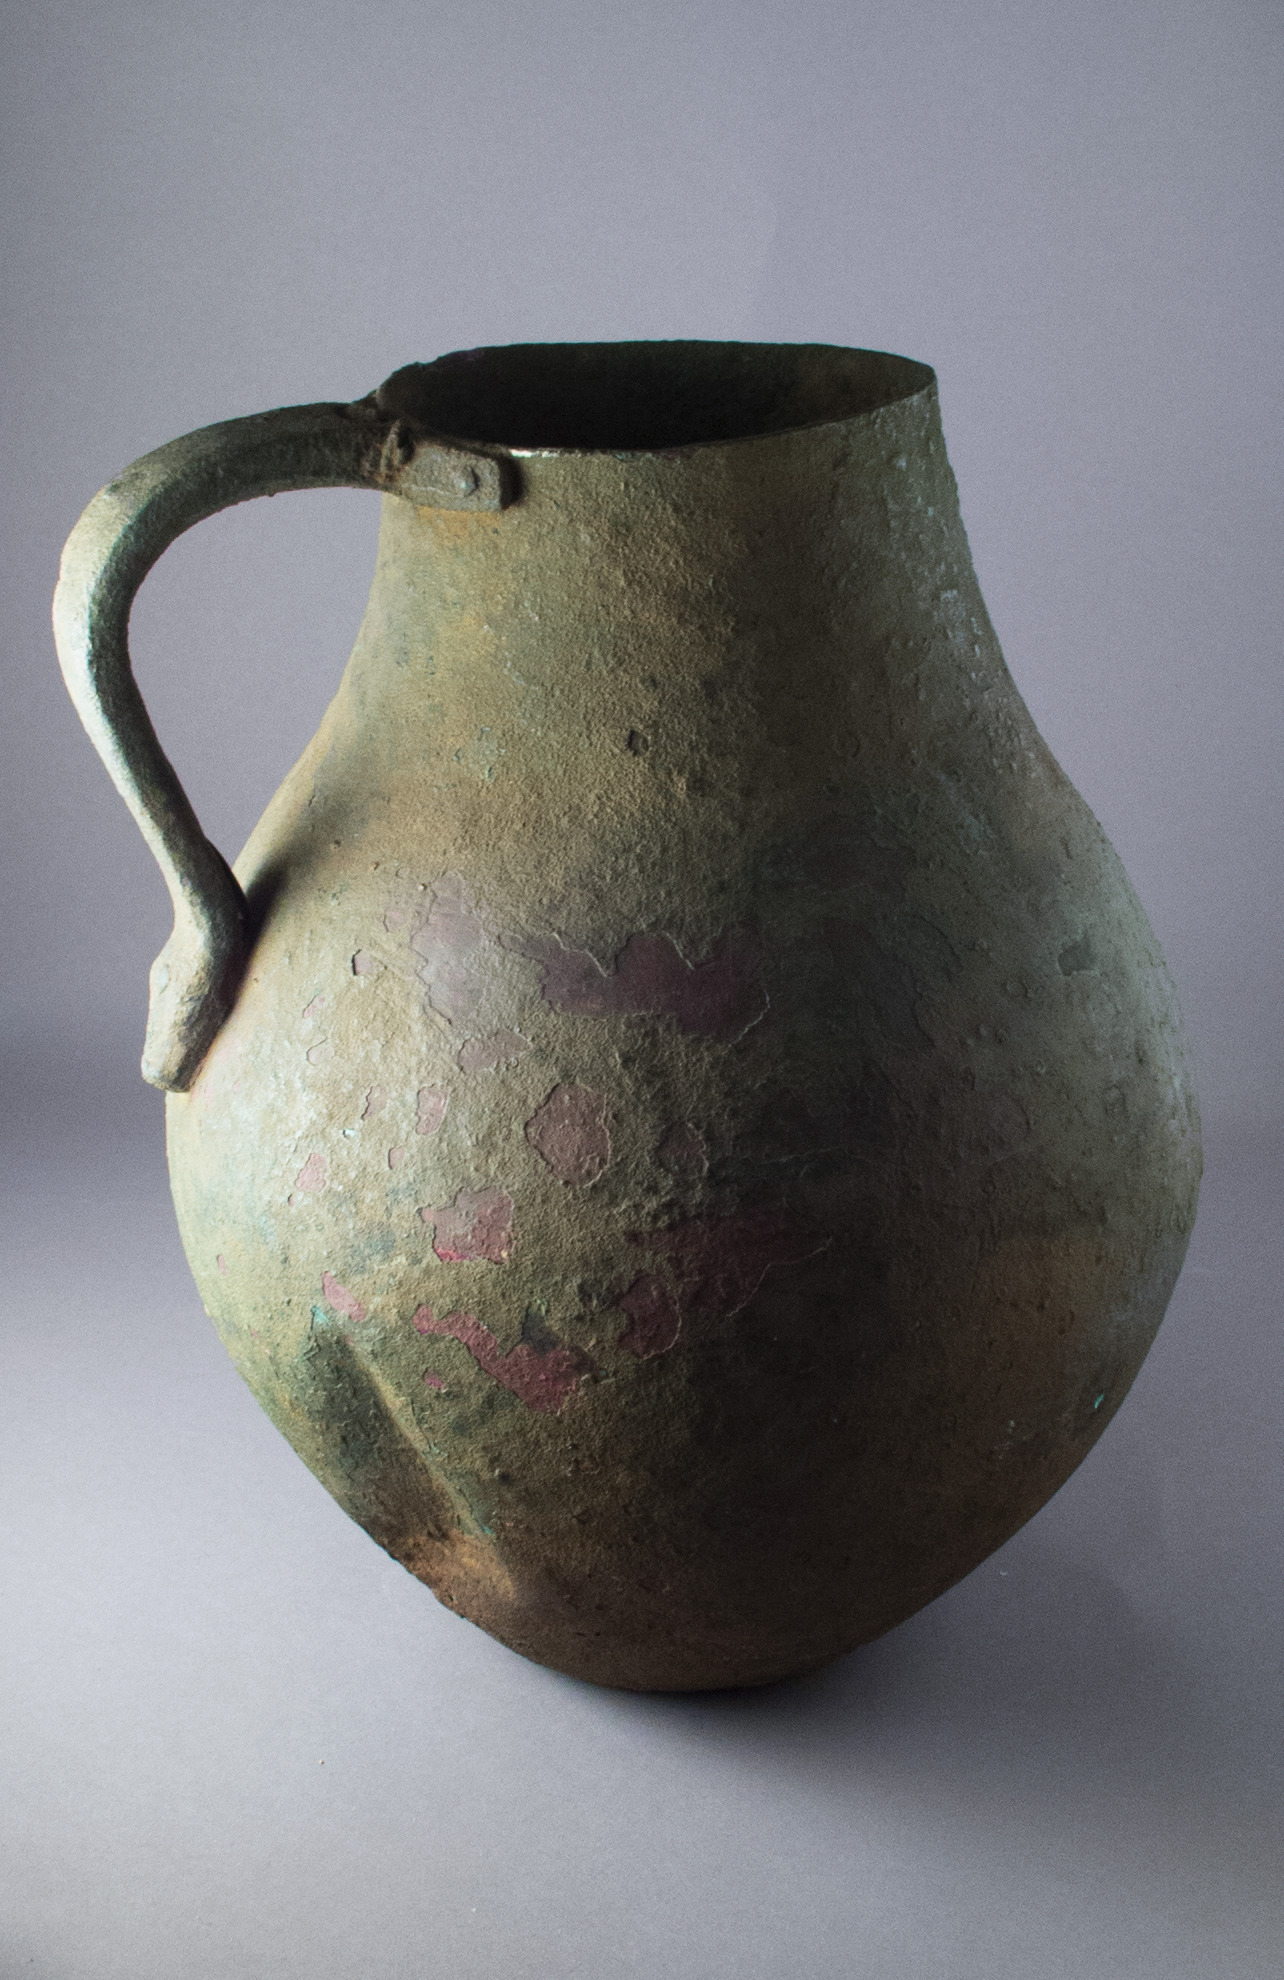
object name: jug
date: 1250-500 BCE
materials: bronze